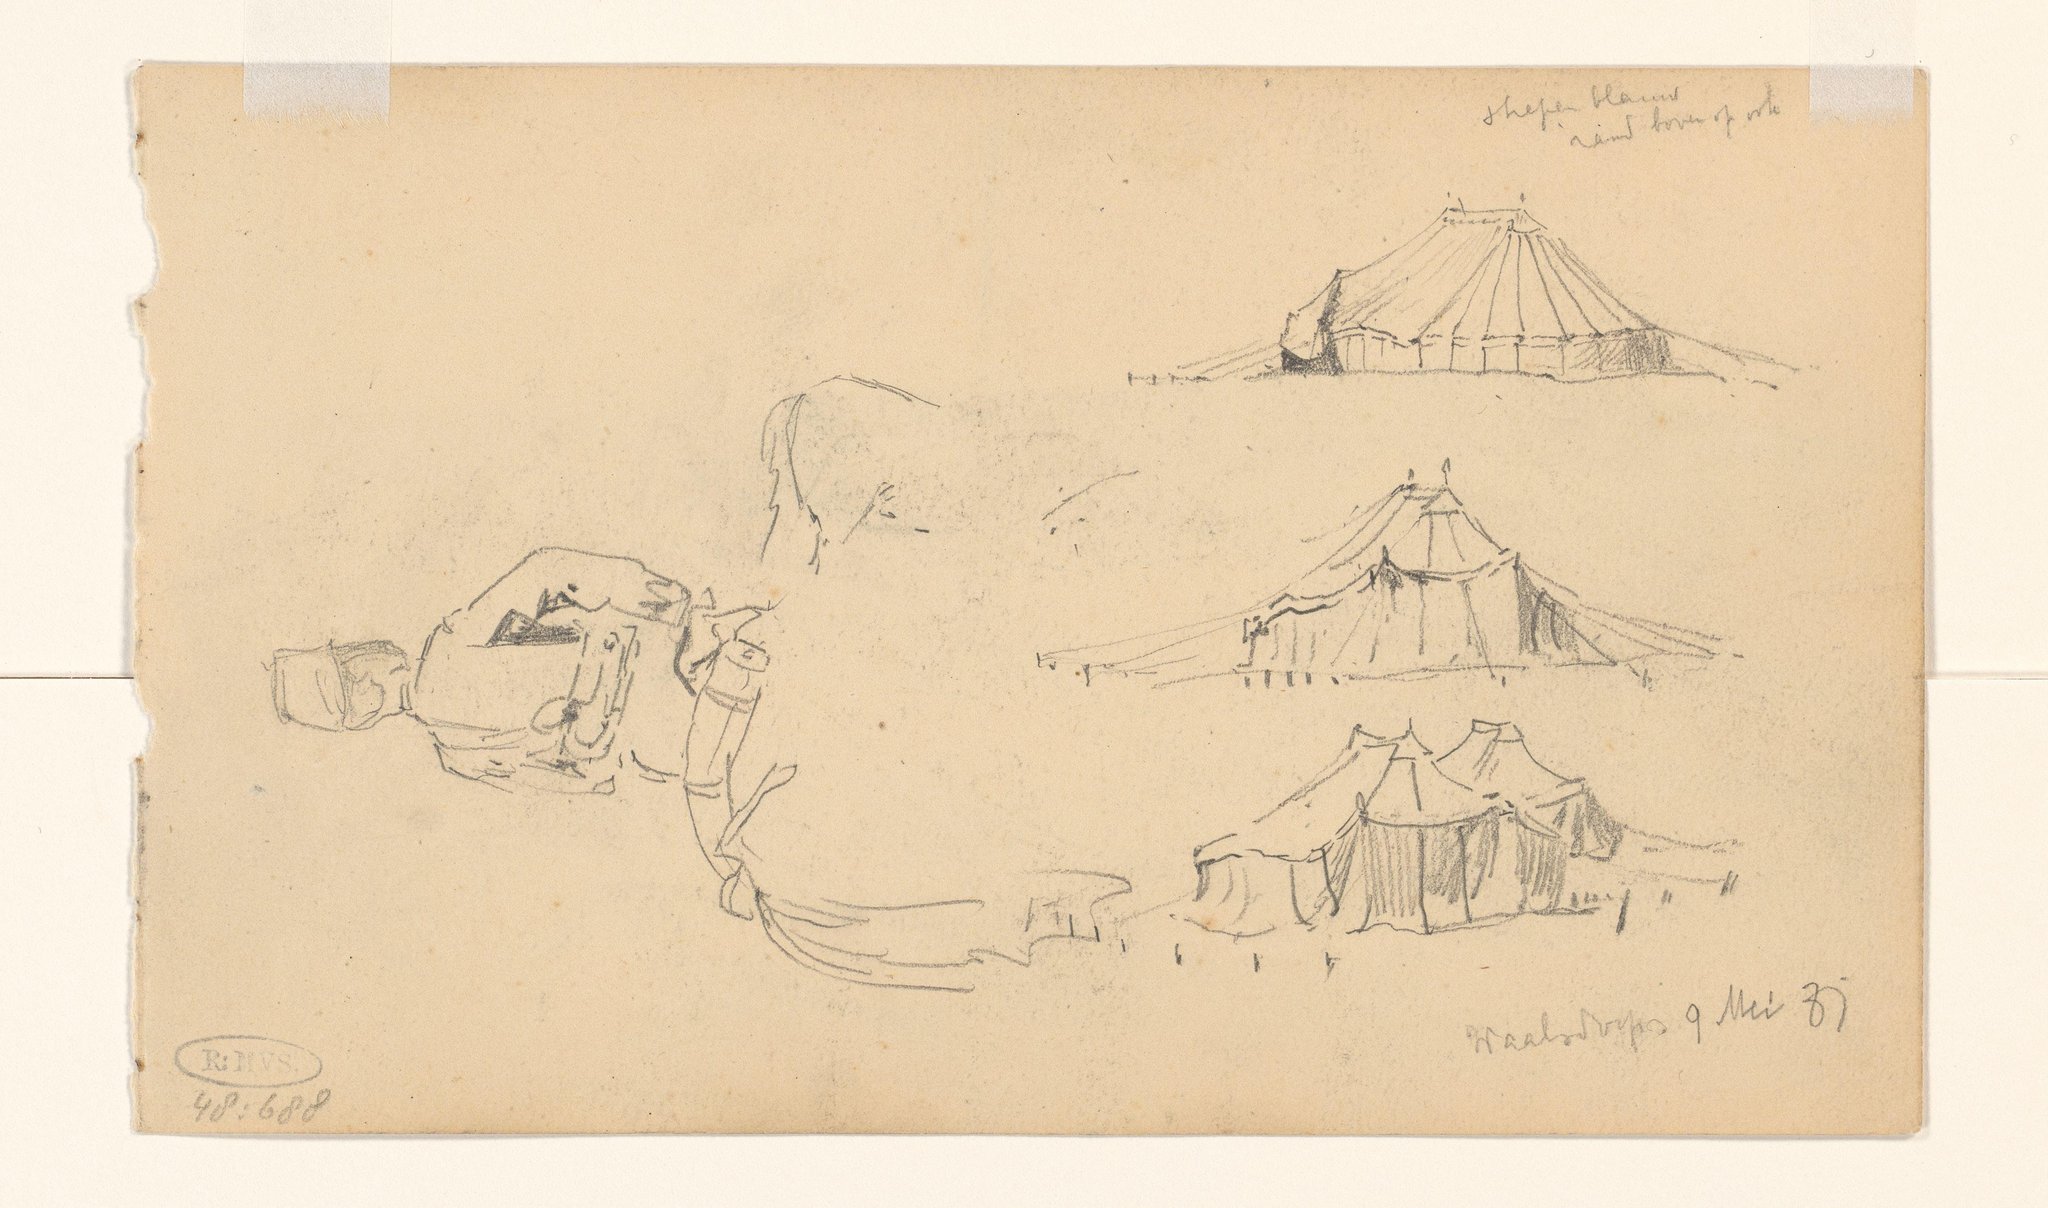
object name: drawing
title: Tenten en een cavalerist bij Waalsdorp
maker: jan hoynck van papendrecht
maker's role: draughtsman, painter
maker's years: 1858-1933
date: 1887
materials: paper, pencil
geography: waalsdorp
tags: riding a horse, ass, or mule; rider, horseman, tent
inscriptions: annotation: ‘Waalsdorp. 9 mei 87’